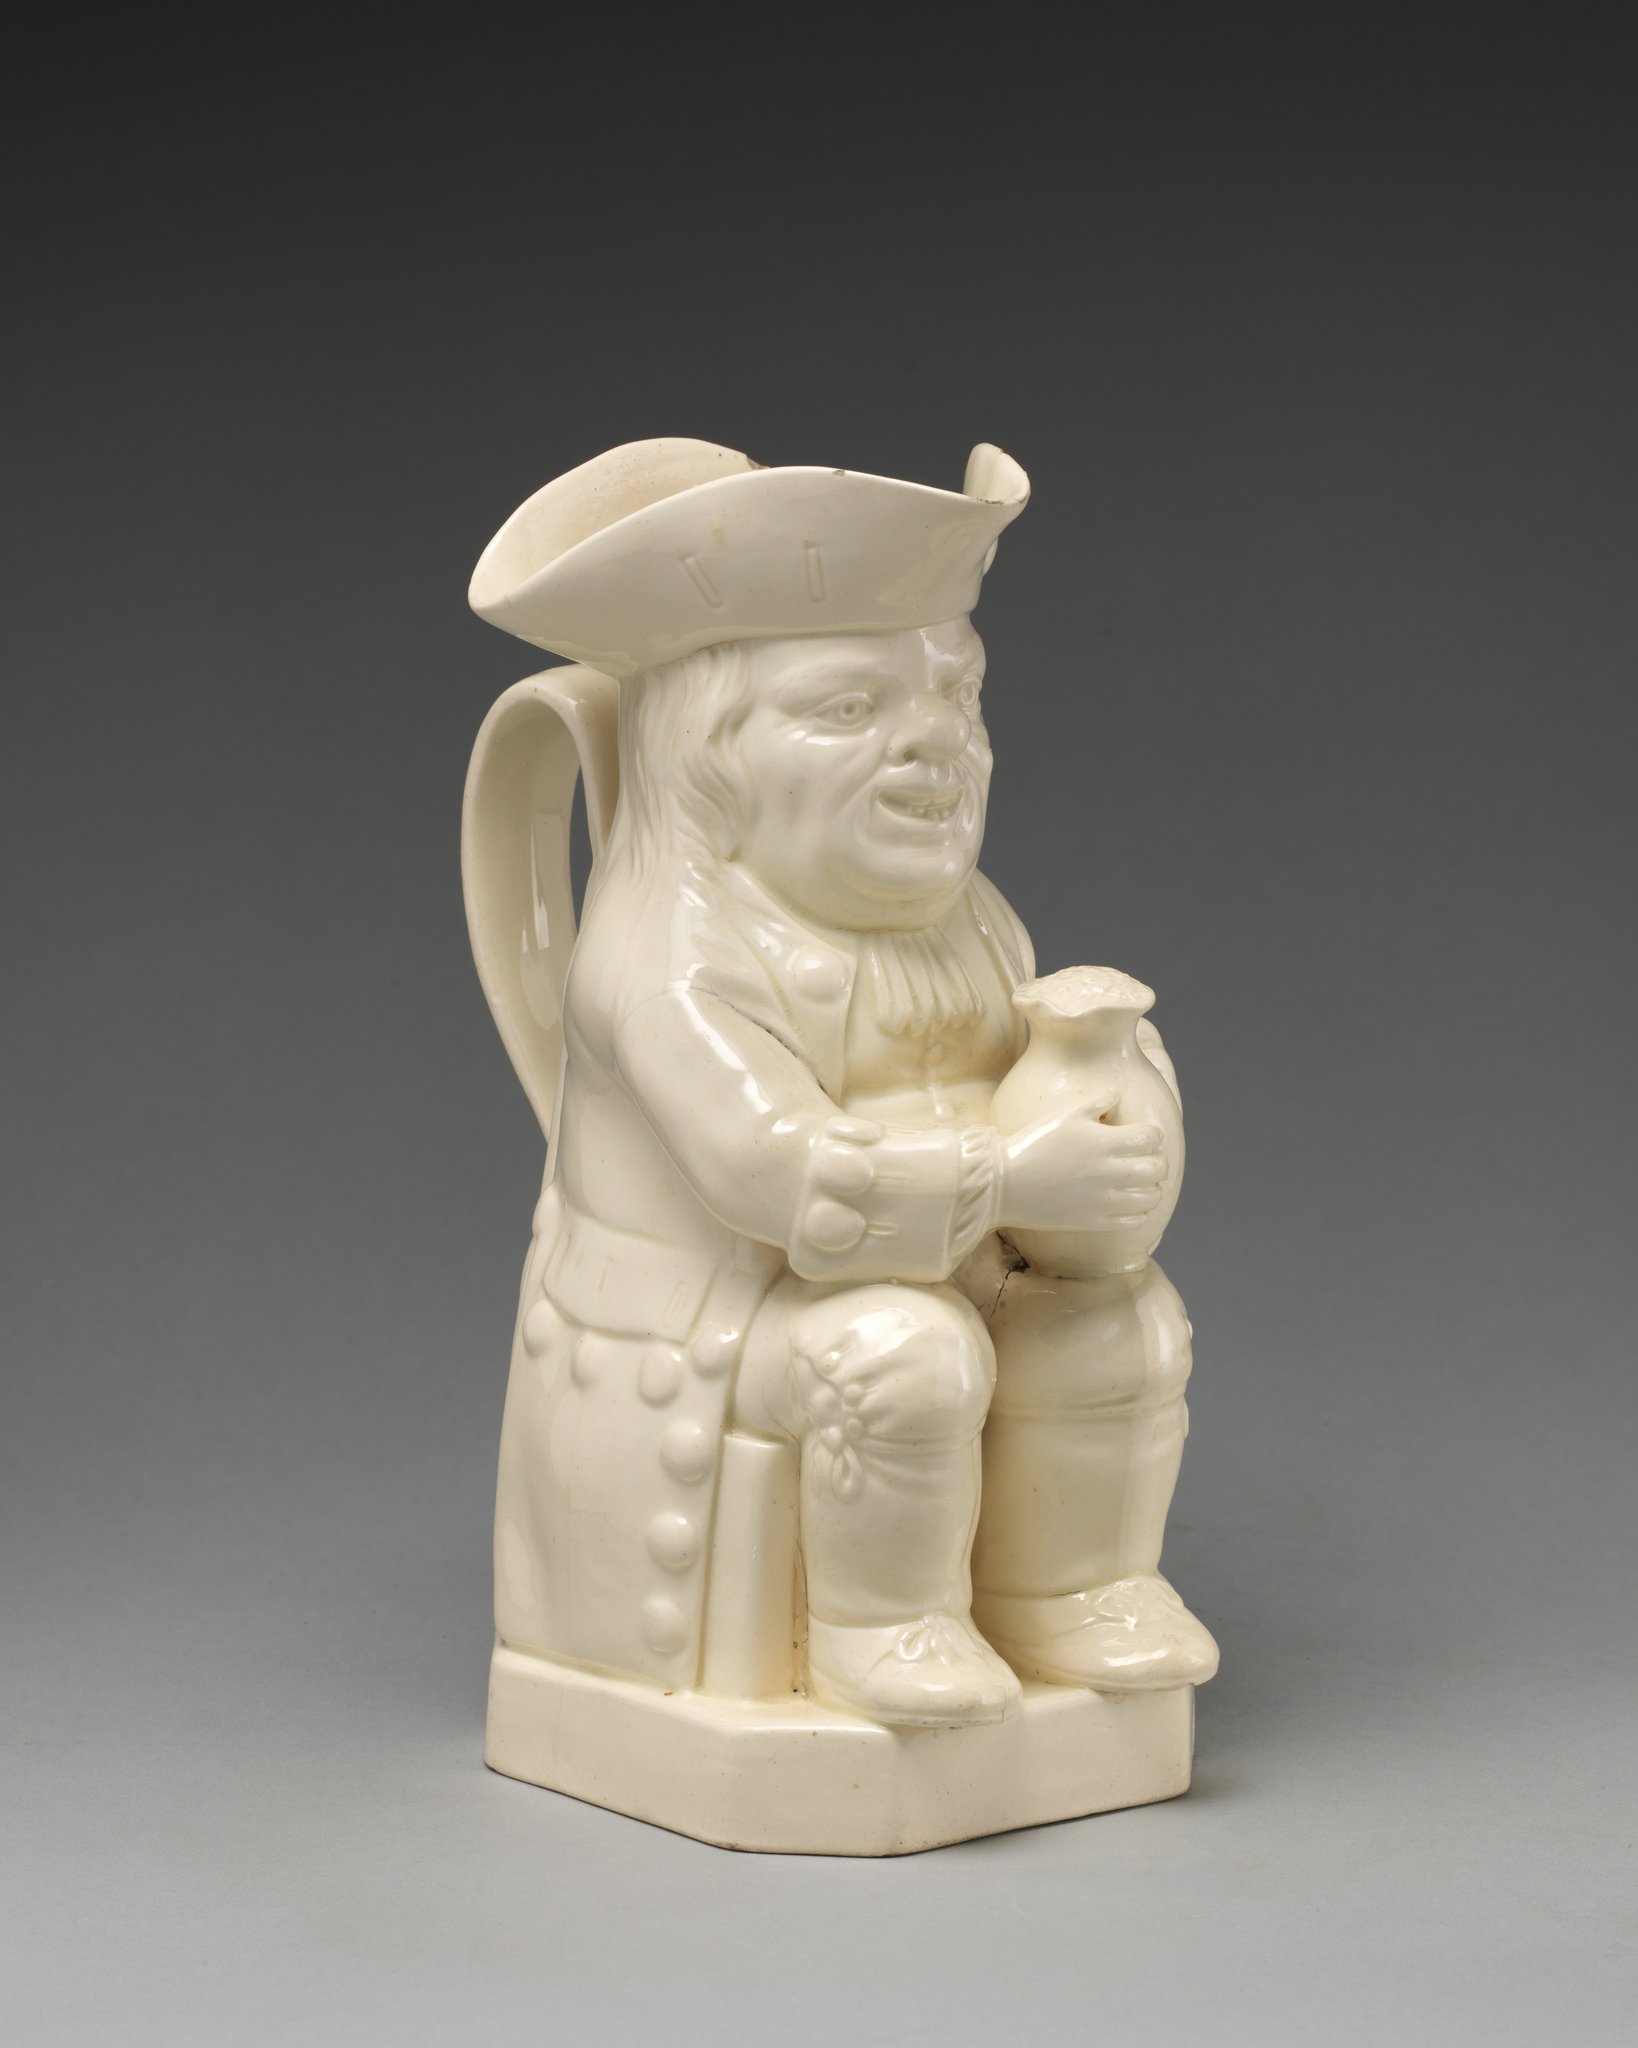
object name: toby jug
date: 1780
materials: creamware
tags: men